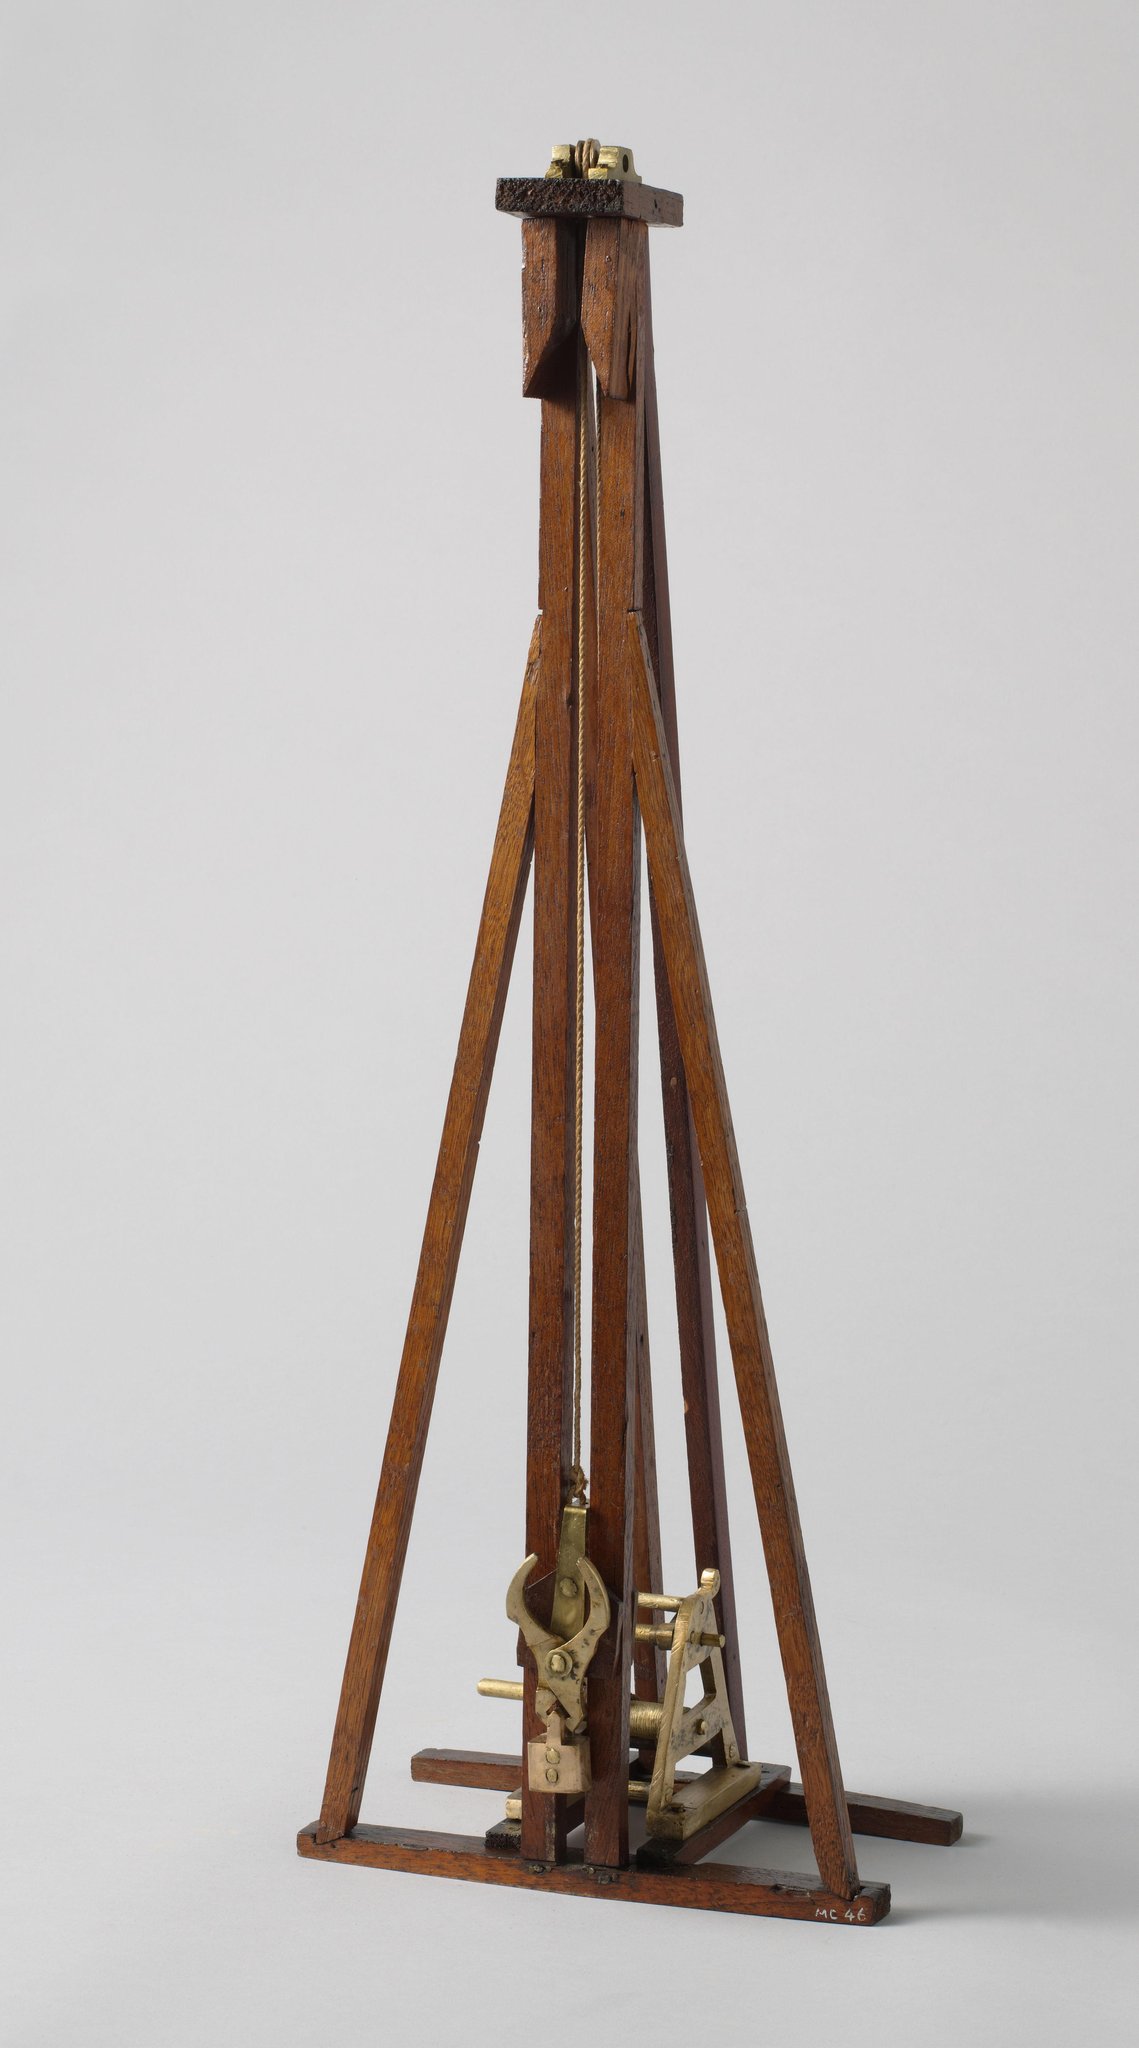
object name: demonstration model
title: Model of a Pile Driver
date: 1819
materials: brass, fiber, wood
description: In 1819 maakte een model van een heitoestel met schaar deel uit van een collectie technische voorwerpen en modellen, die door Gerard Moritz Roentgen uit Groot-Brittannië naar de Rijkswerf te Rotterdam werd gestuurd. Vandaar werden de stukken aan de Marinemodellenkamer in Den Haag overgedragen. J.C. Rijk nam gedurende zijn reis met de korvet Pallas naar Noord-Amerika in 1825 ook van dergelijke heistellingen waar.